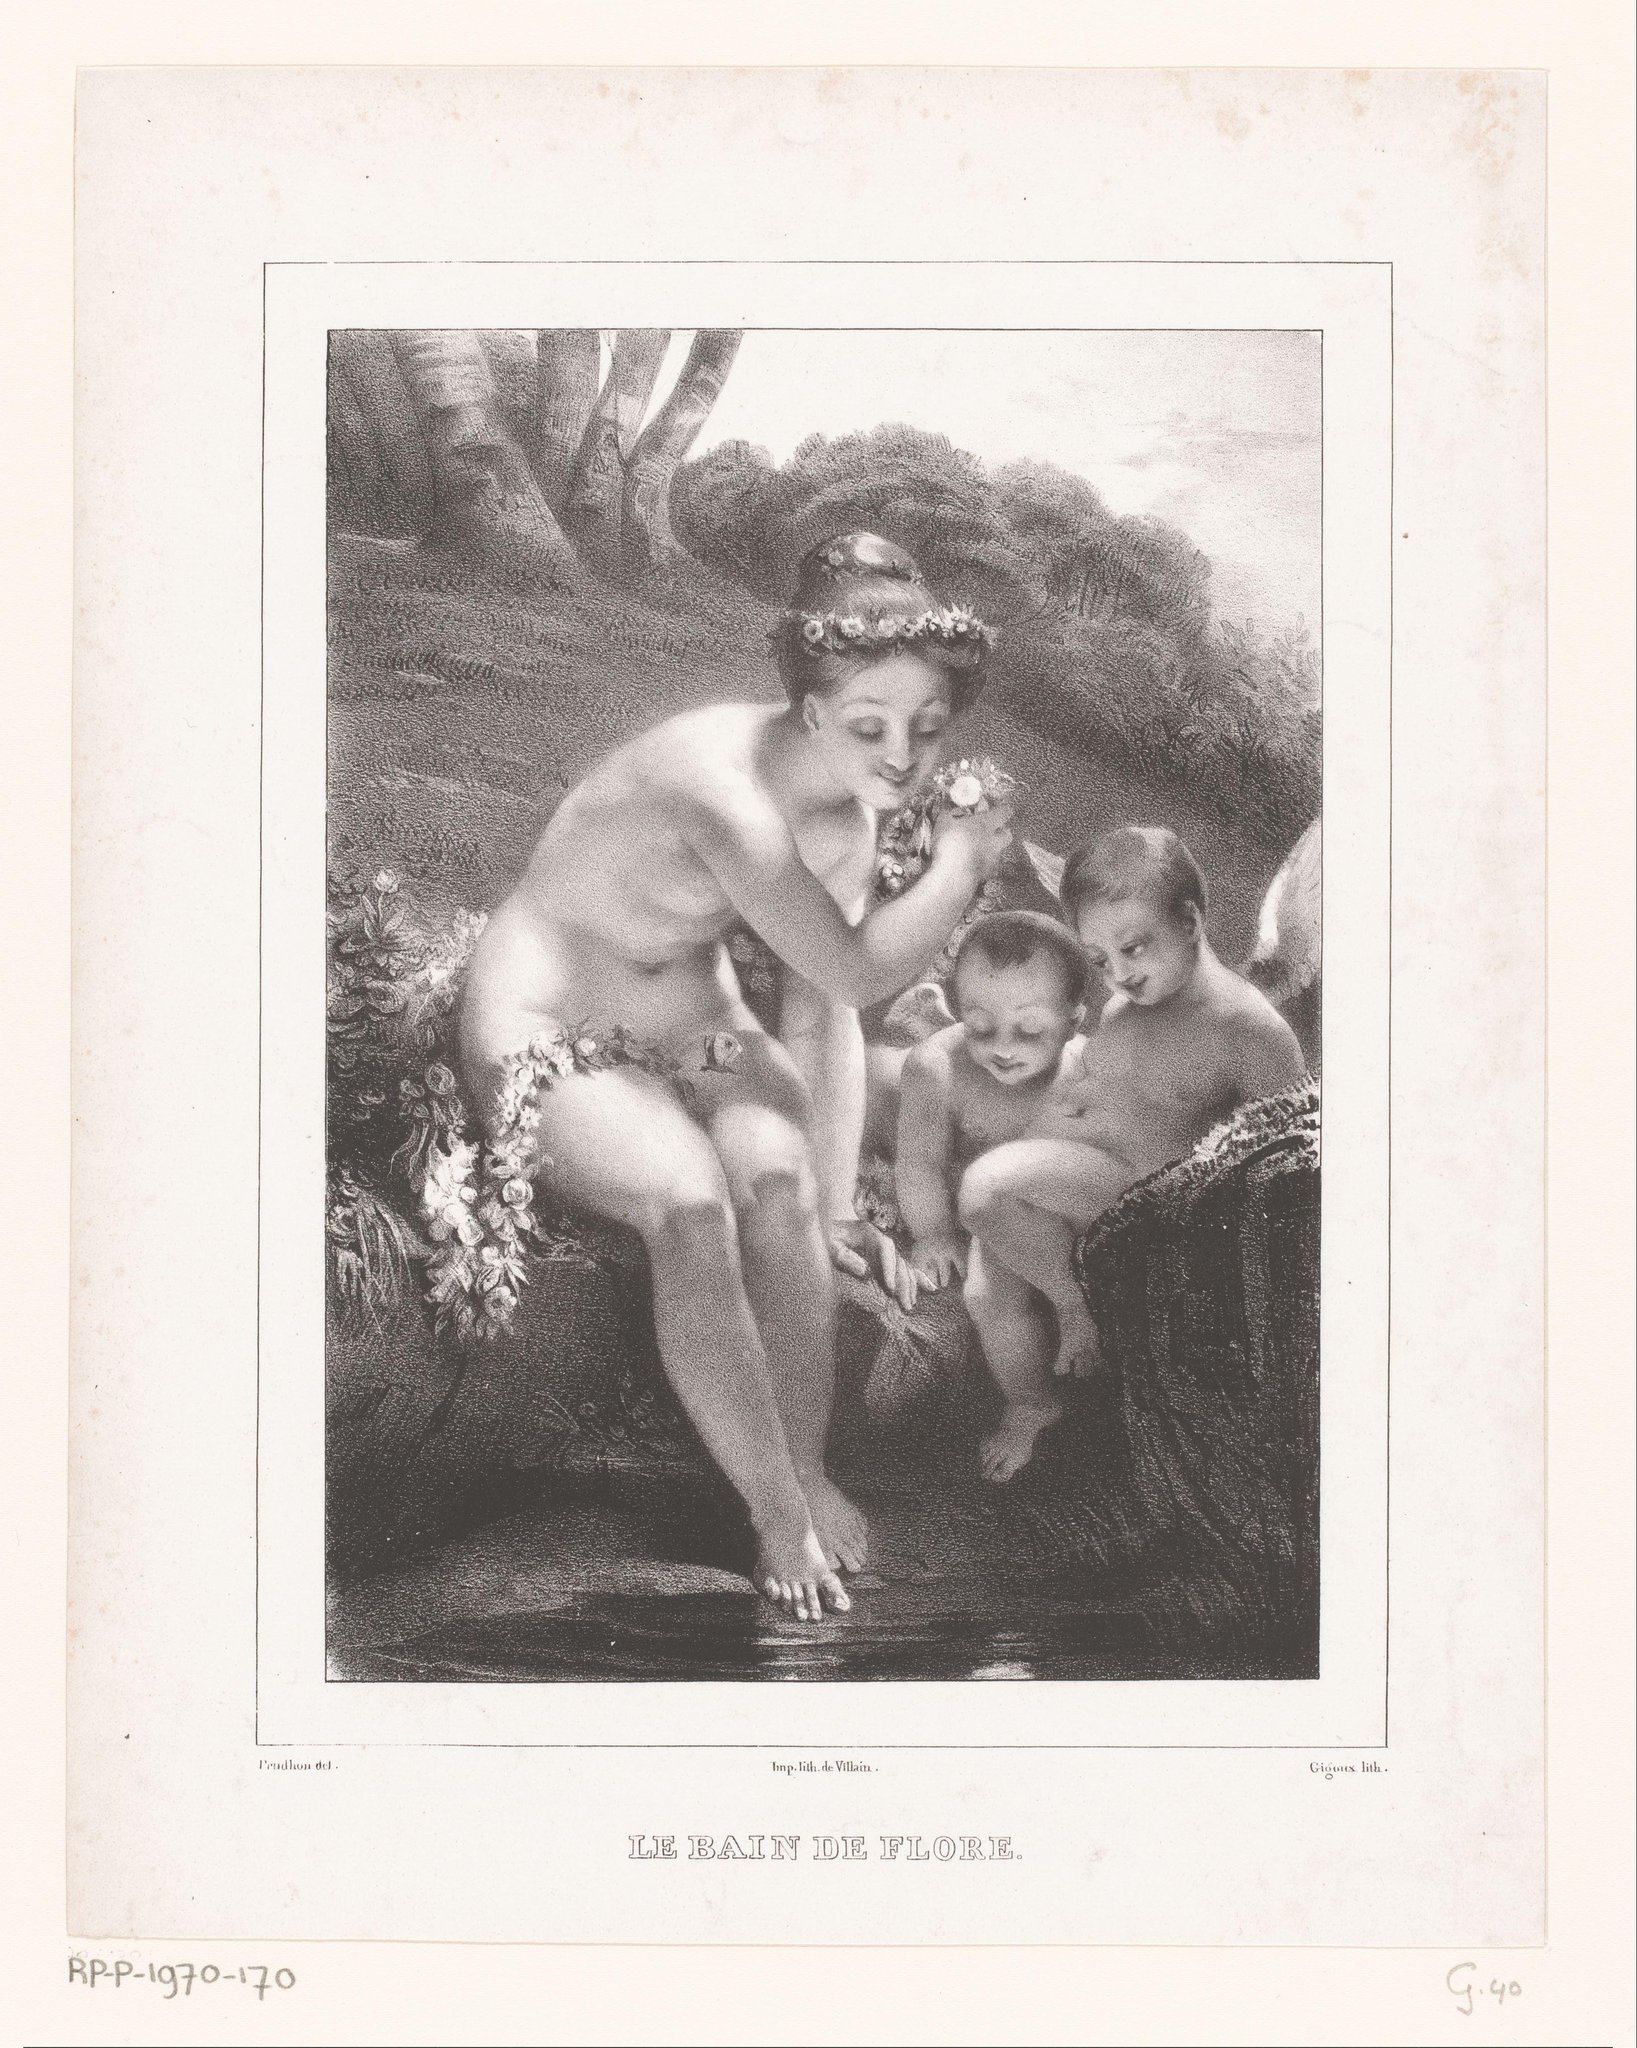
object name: print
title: Le Bain de Flore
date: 1832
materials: paper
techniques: lithograph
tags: (story of) flora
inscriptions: collector's mark: Lugt 2228a, collector's mark: Lugt 2760